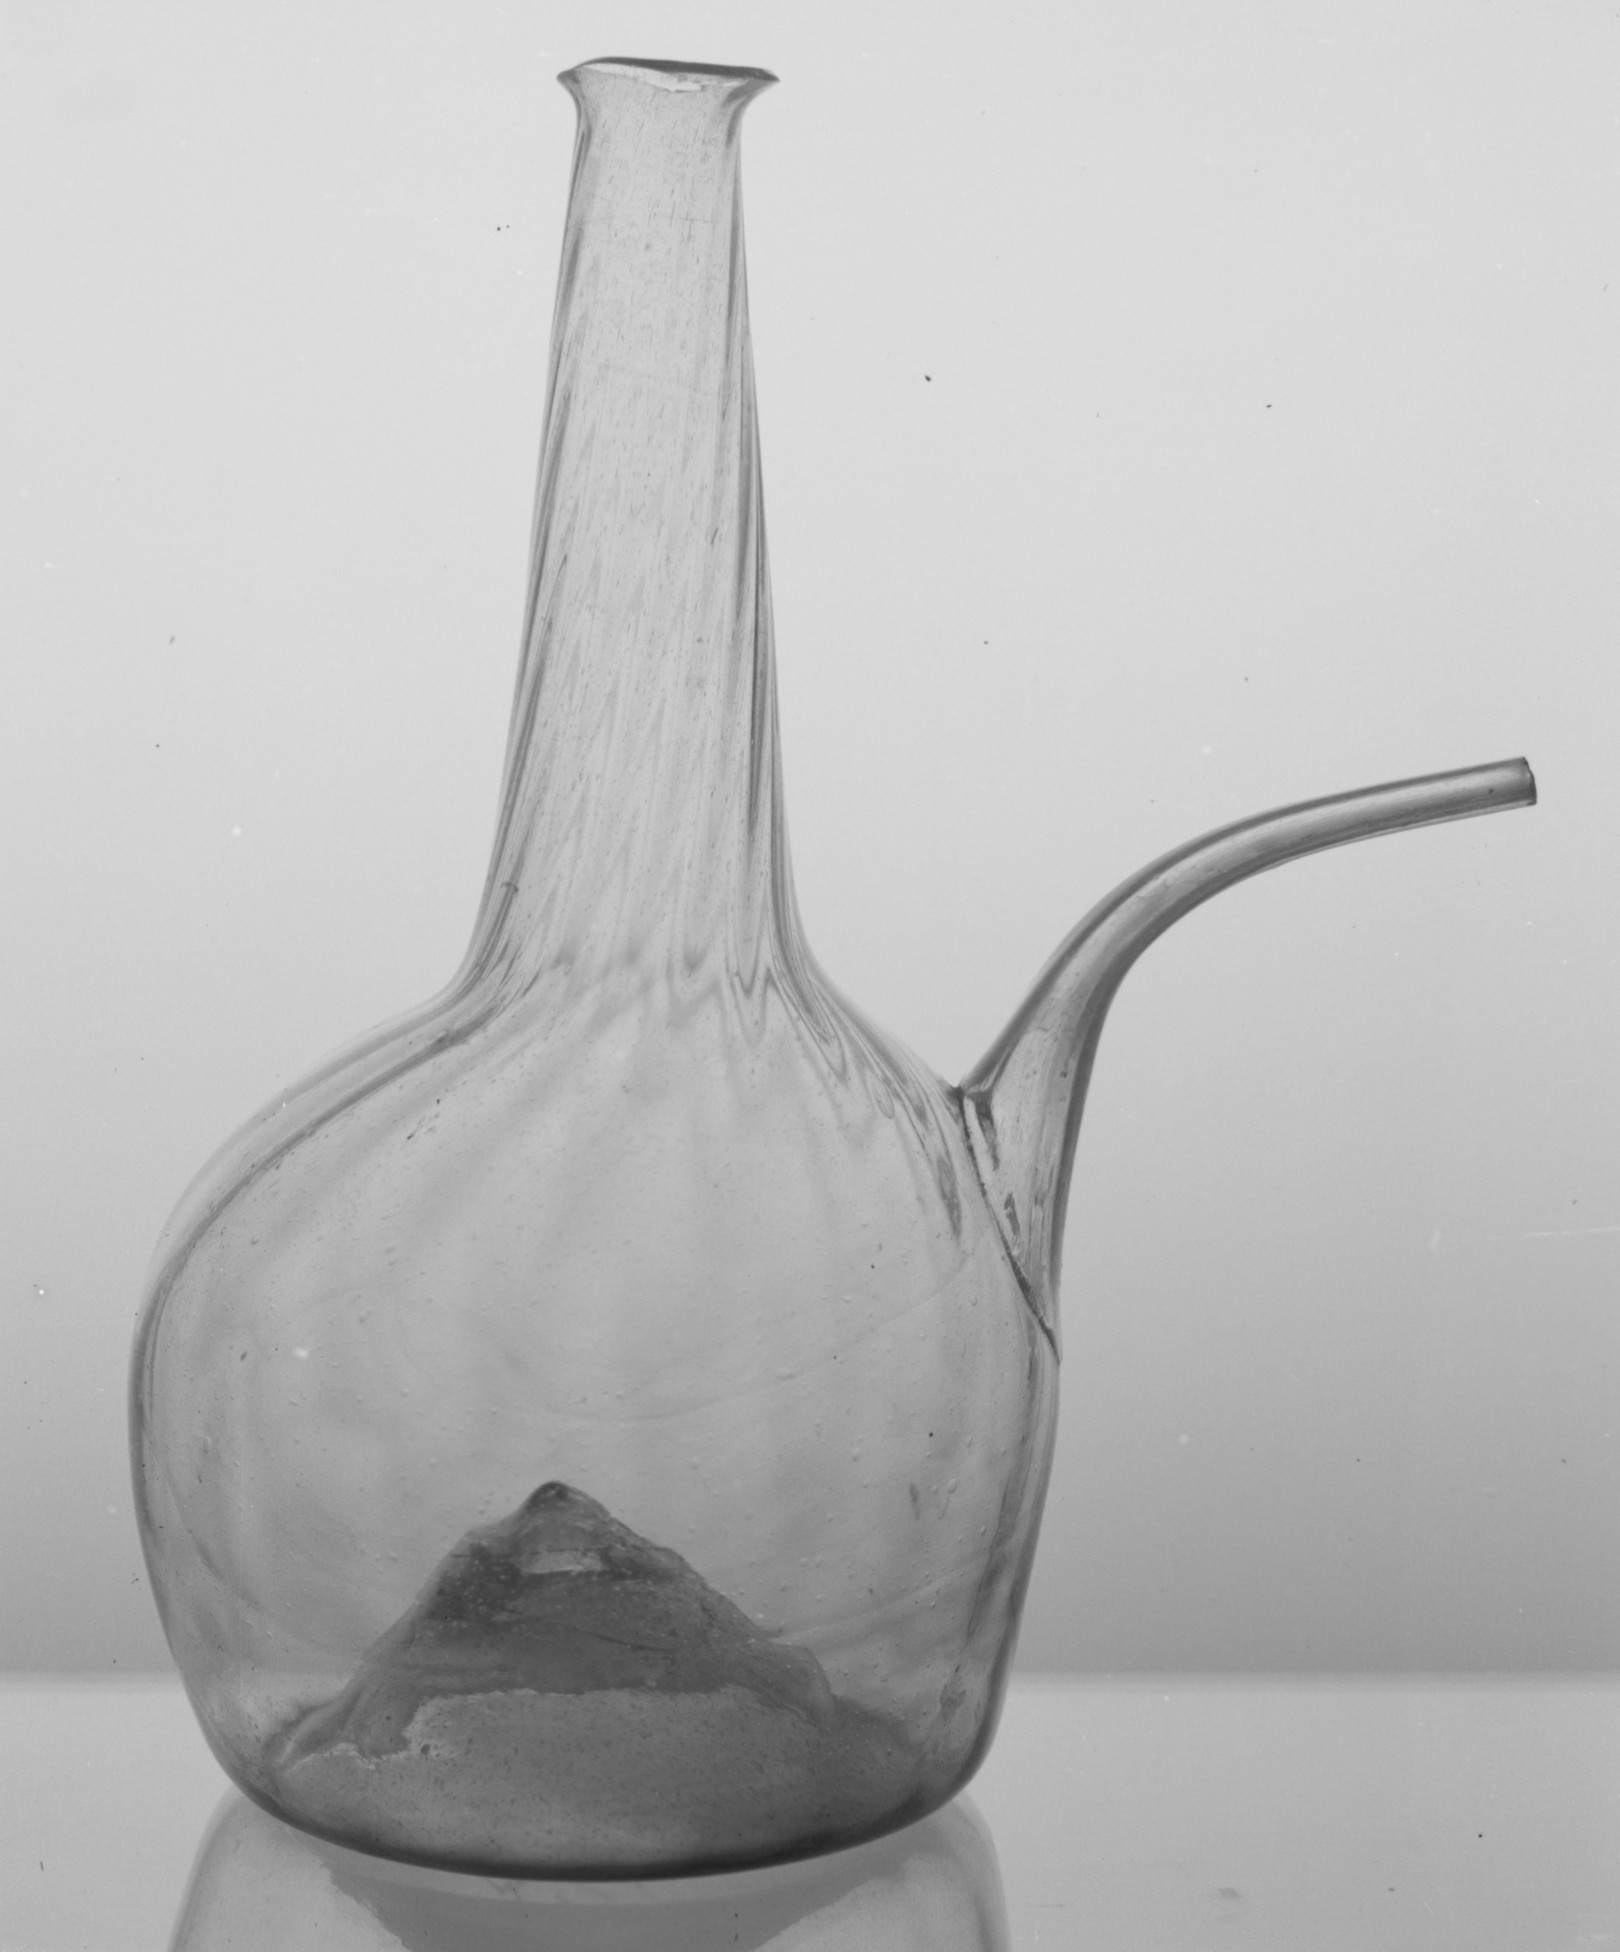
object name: wine vessel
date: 1701-1800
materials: glass